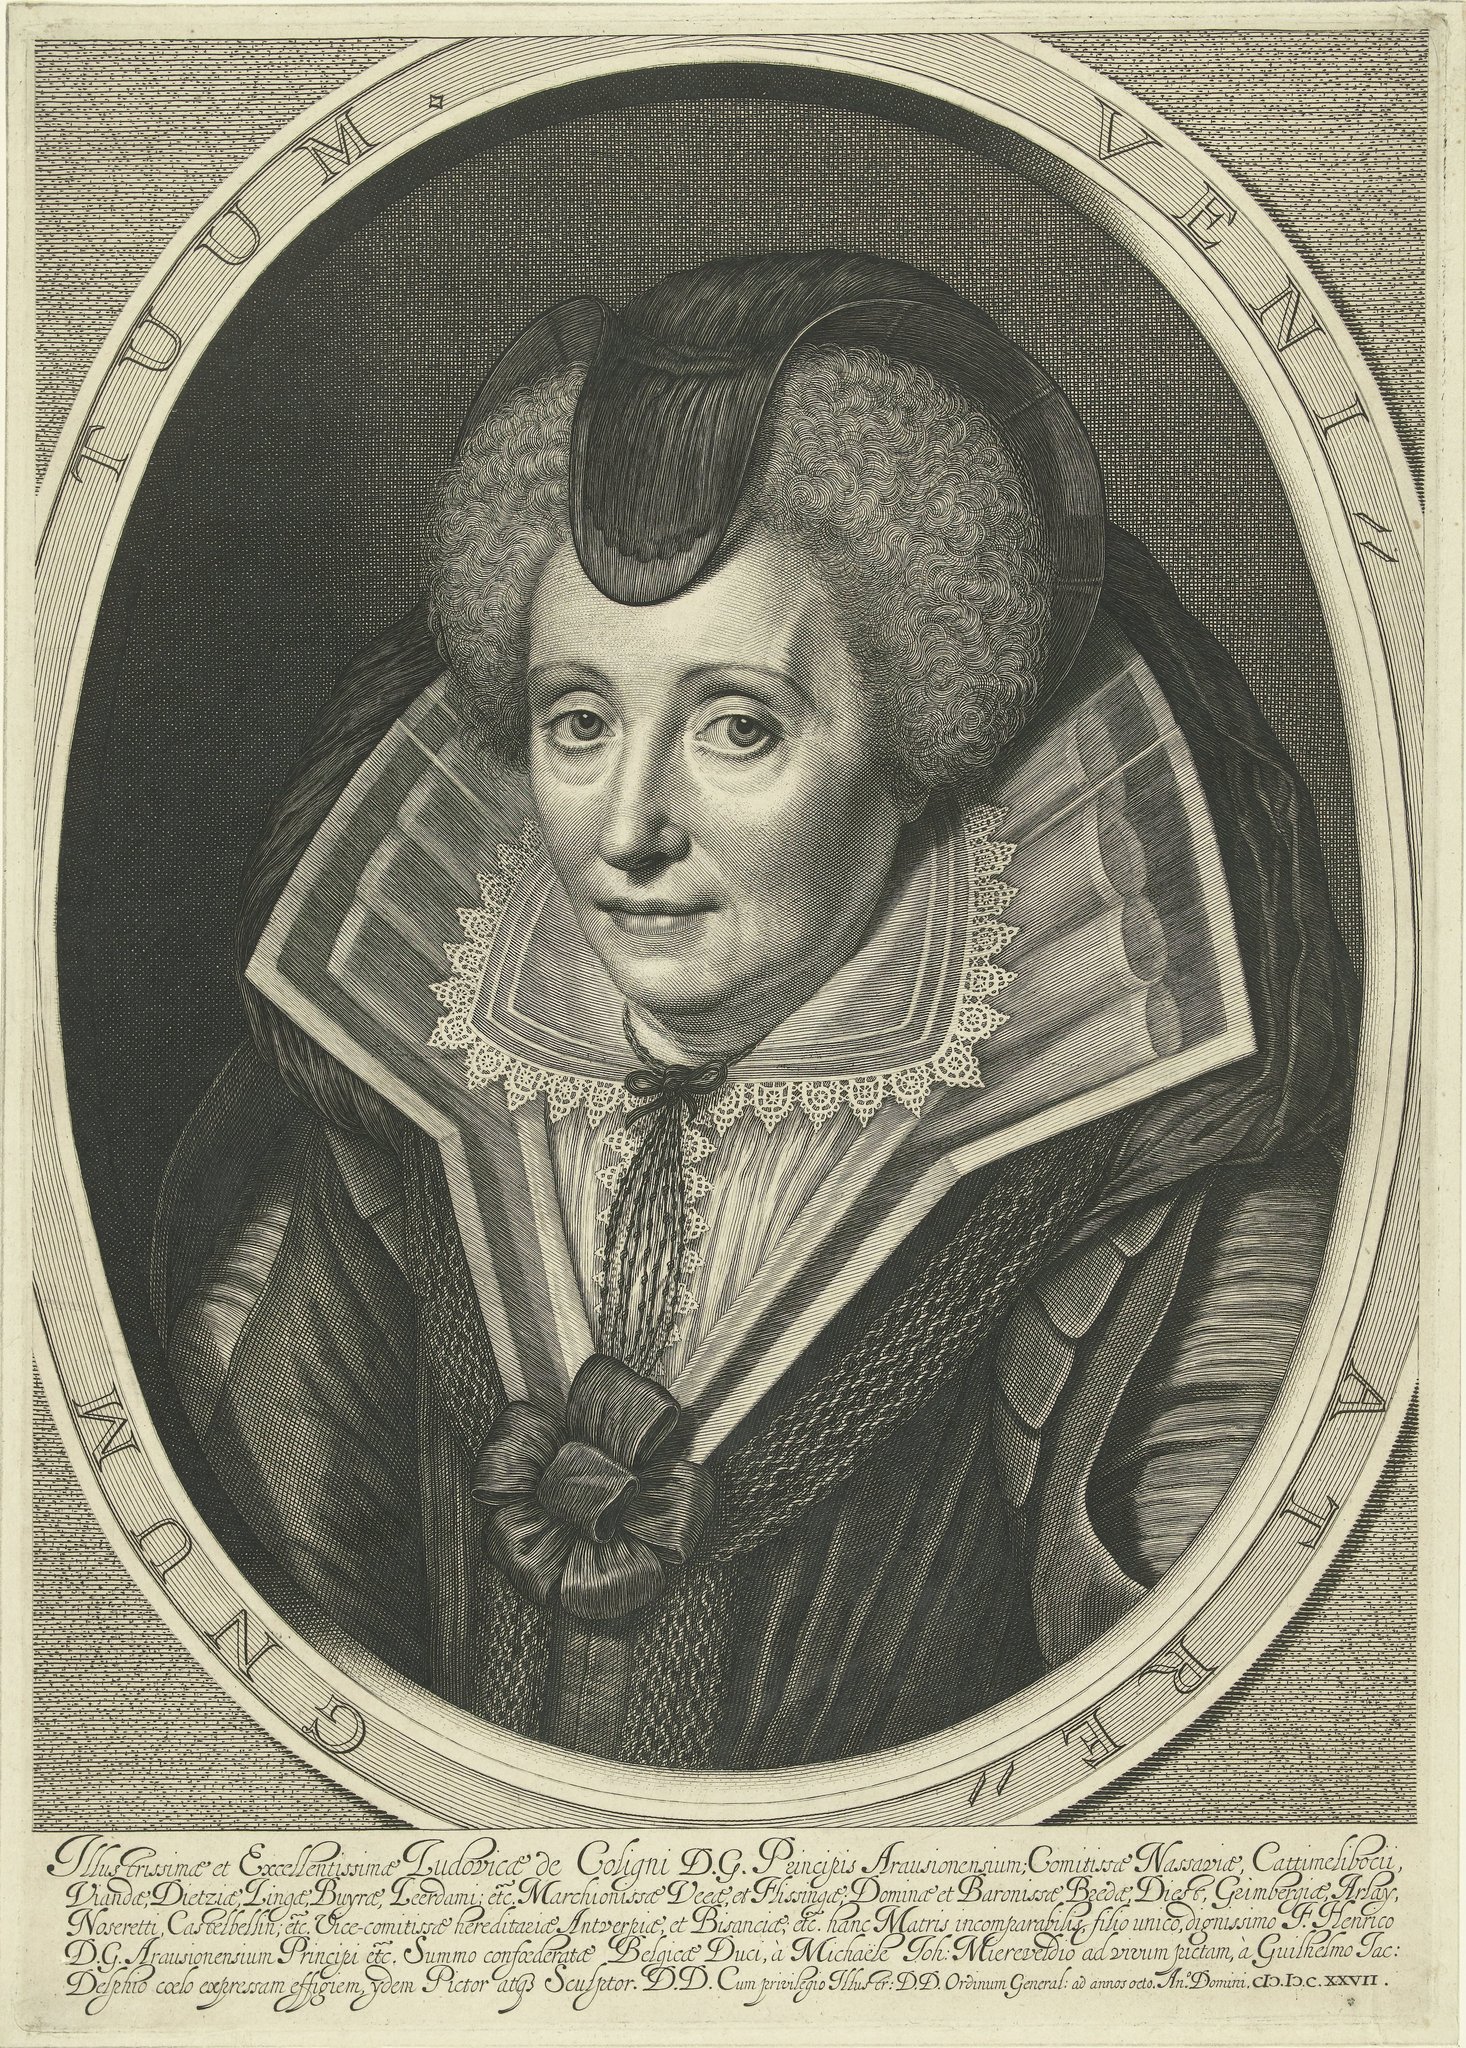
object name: print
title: Portret van Louise de Coligny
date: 1627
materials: paper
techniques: engraving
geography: delft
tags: louise de coligny, neck-gear: collar (+ women's clothes)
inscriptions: collector's mark: Lugt 240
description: Portret van Louise de Coligny, vierde vrouw van Willem I van Oranje, borststuk met hoog opstaande kraag in ovale omlijsting met motto. In ondermarge vijf regels Latijns opschrift.